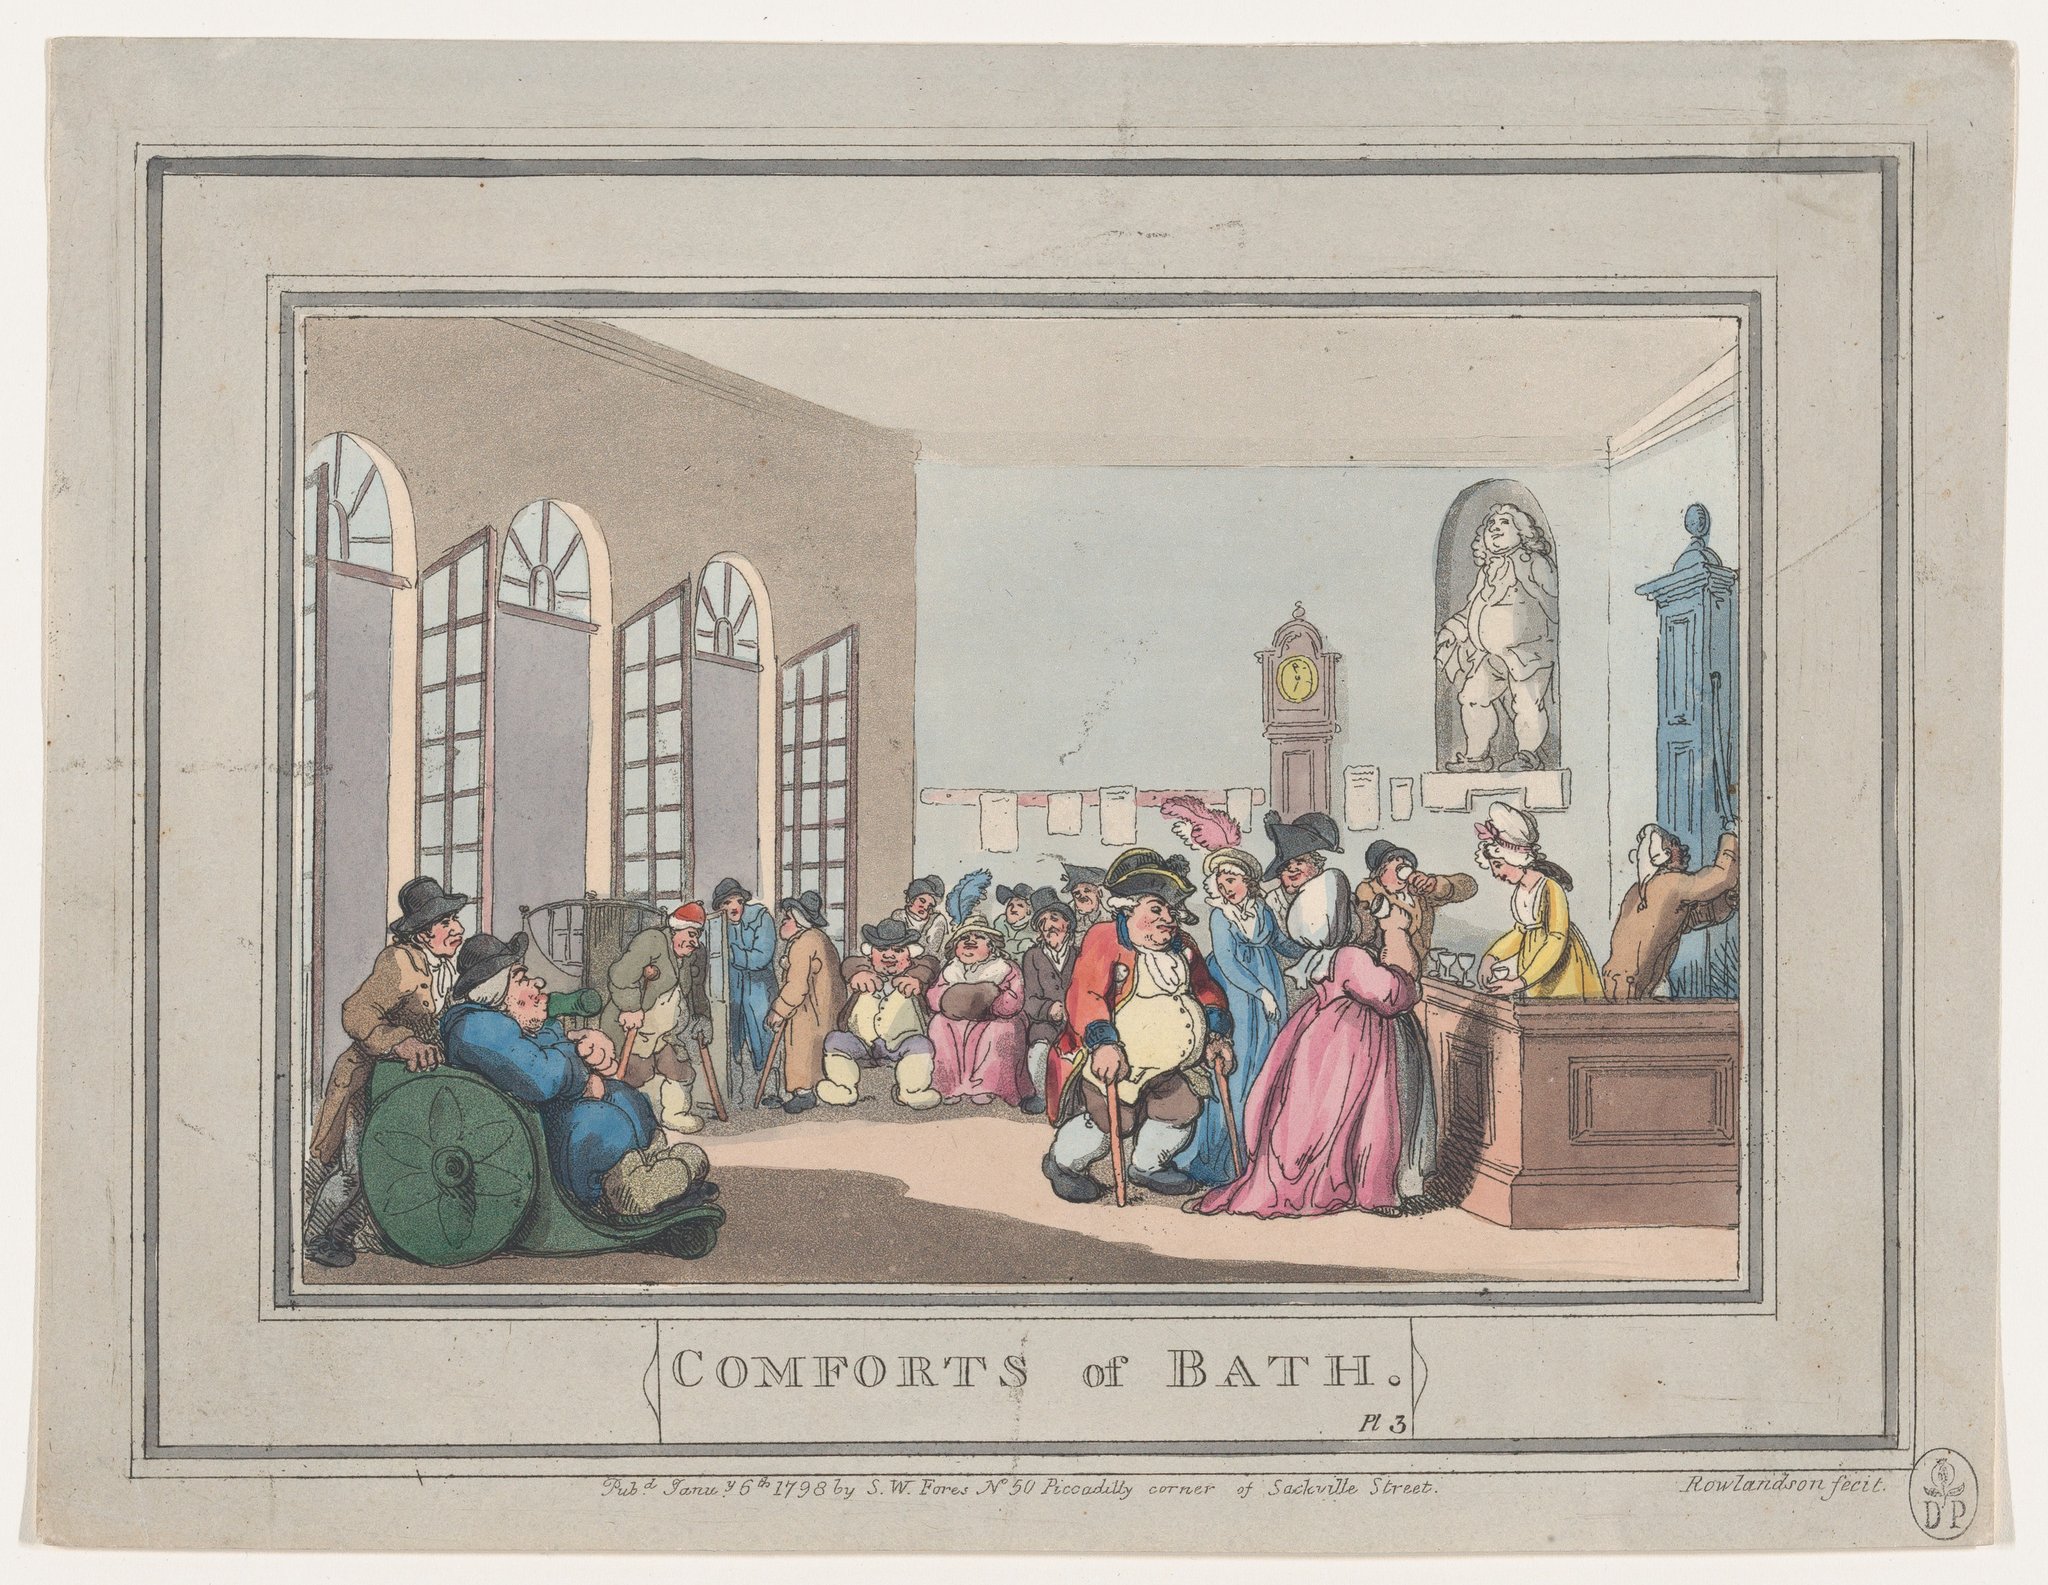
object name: print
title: Comforts of Bath, Plate 3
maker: thomas rowlandson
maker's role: artist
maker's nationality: british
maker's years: 1757-1827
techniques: aquatint, etching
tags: satire,men,women